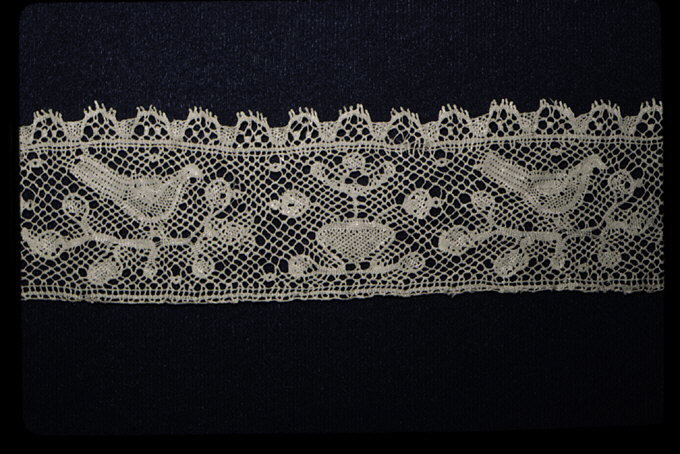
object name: strip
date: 1701-1800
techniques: lace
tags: birds